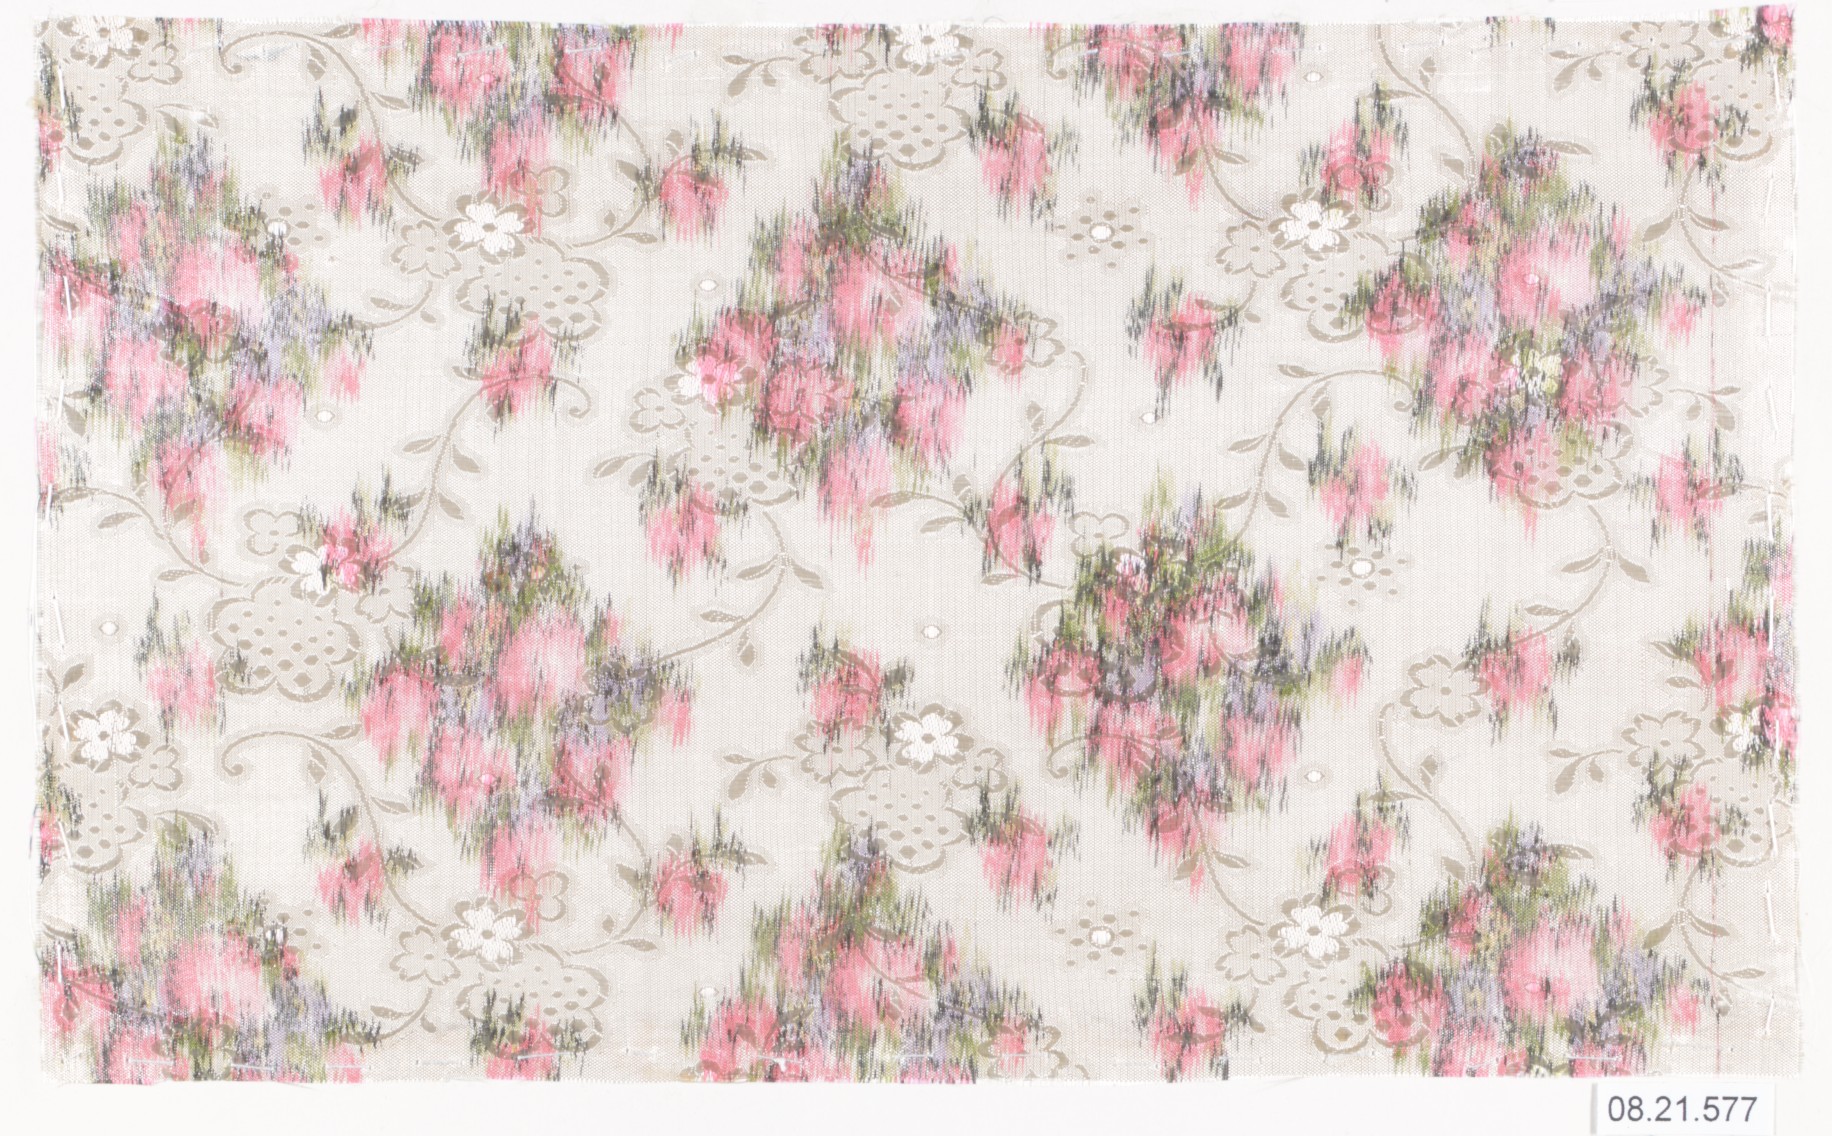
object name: textile sample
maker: Anonymous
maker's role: designer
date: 1900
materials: silk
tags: flowers